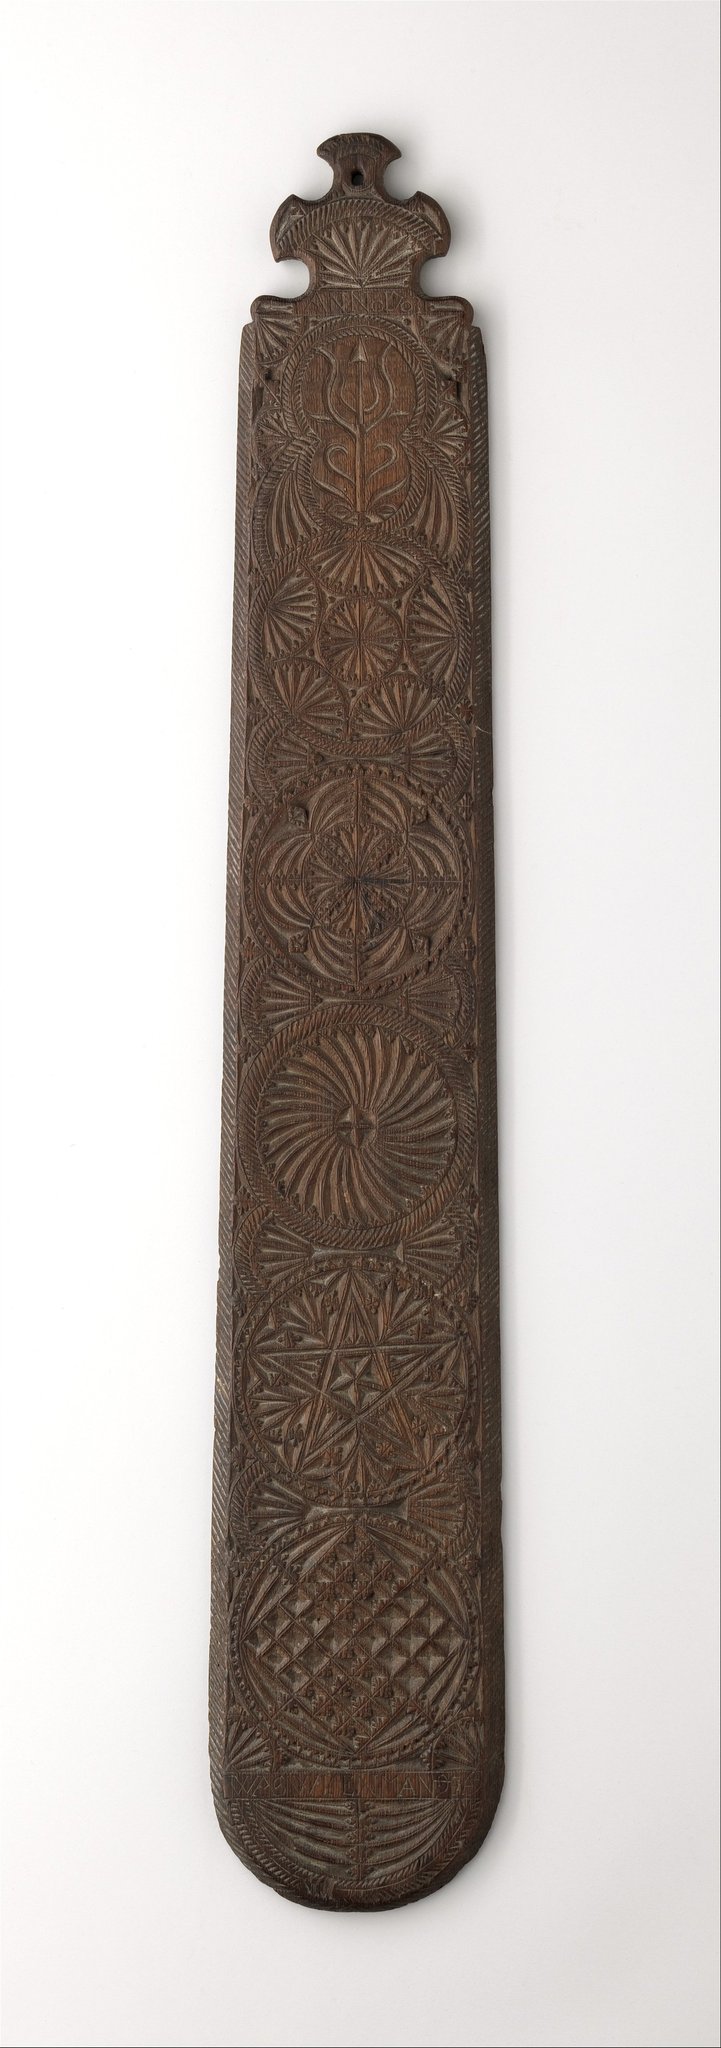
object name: mangle board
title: Mangle-board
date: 1701-1800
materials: wood